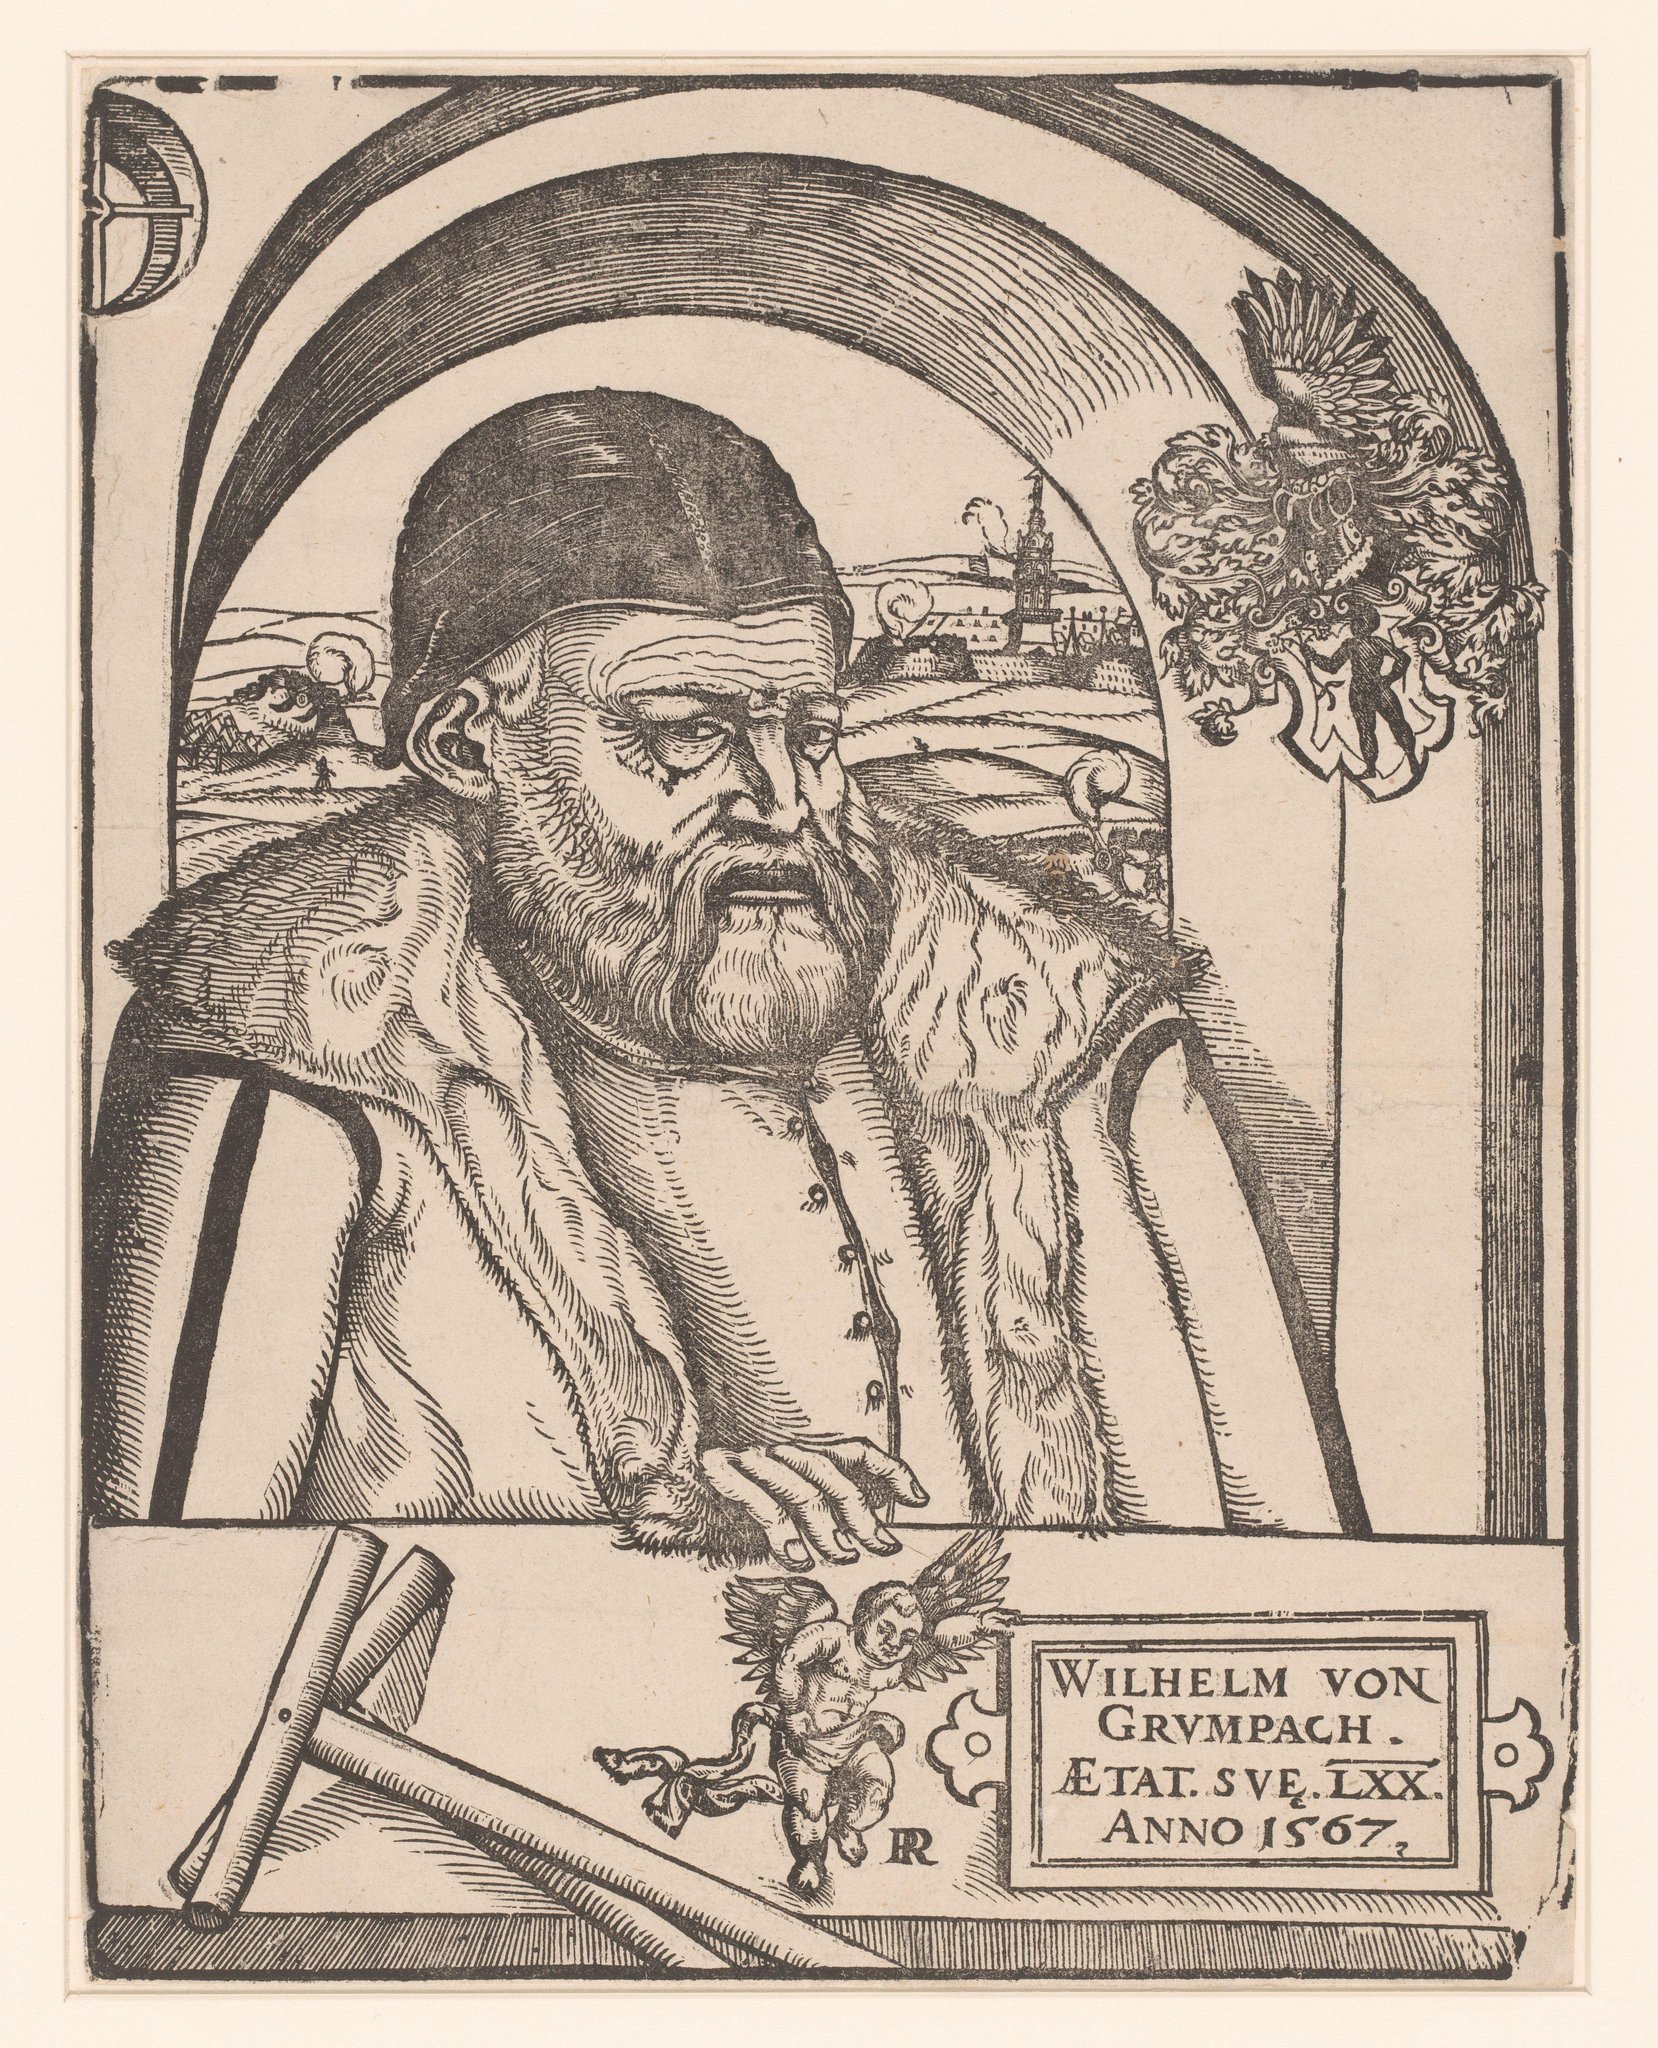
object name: print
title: Portret van Wilhelm von Grumbach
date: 1567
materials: paper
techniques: woodcut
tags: crutches, historical persons, siege, armorial bearing, heraldry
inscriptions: collector's mark: Lugt 1606, collector's mark: Lugt 2228, collector's mark: Lugt 2773